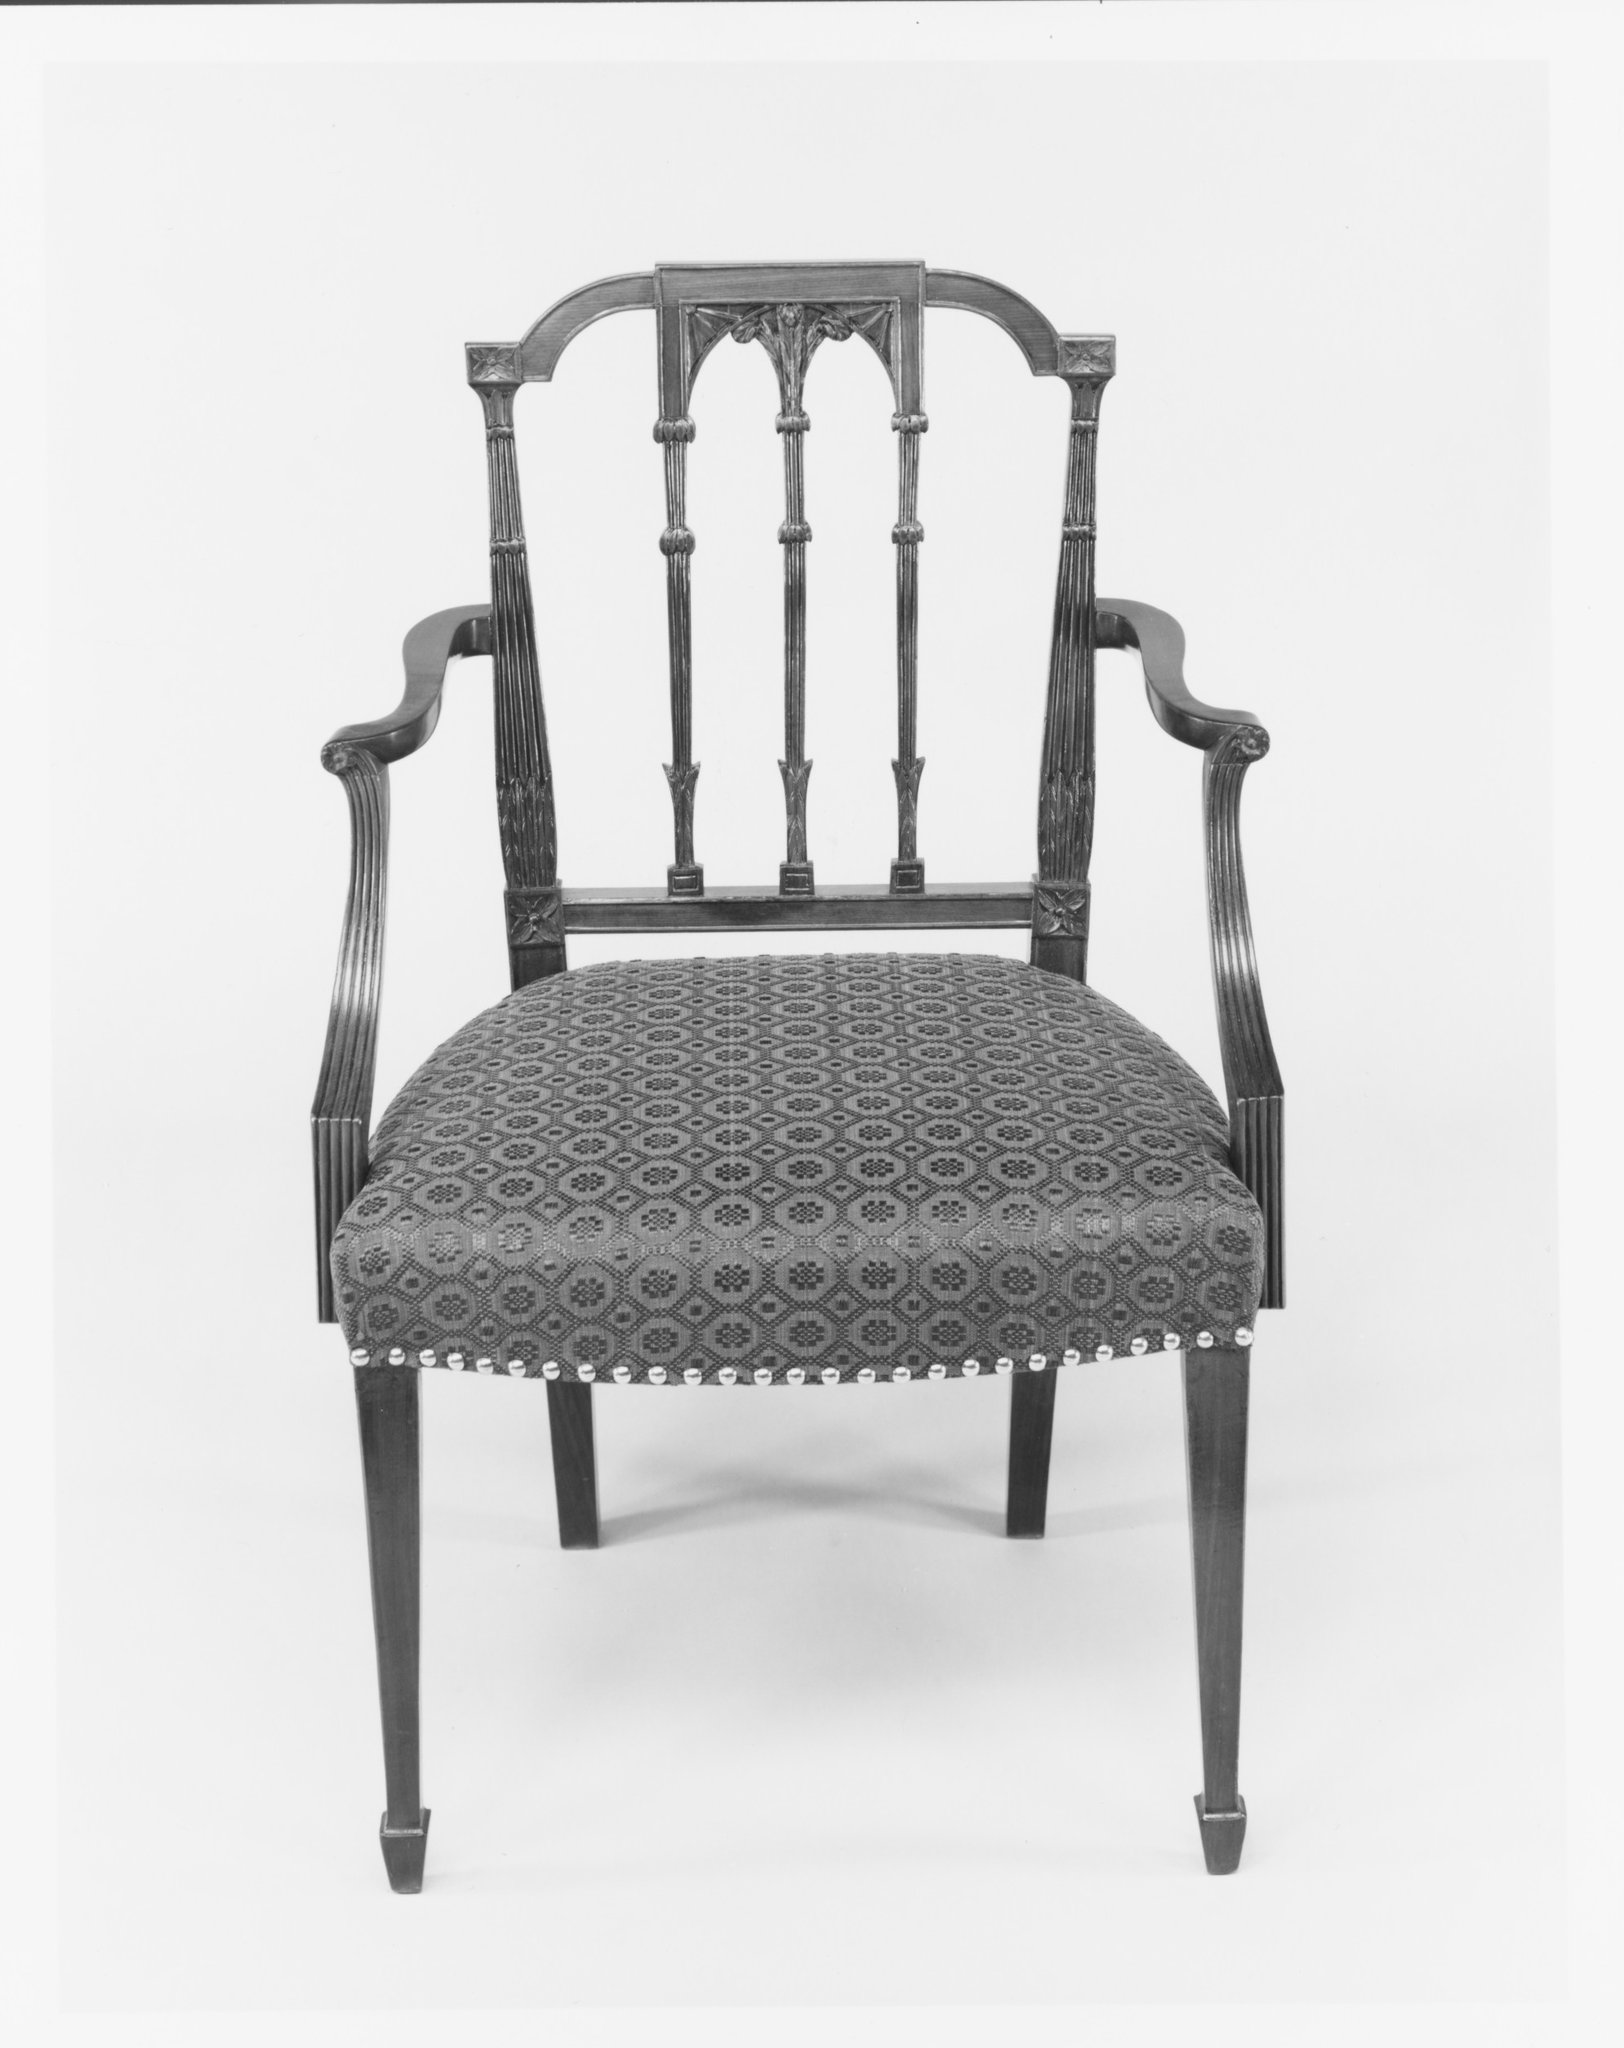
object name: armchair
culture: american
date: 1795-1810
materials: wood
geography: united states